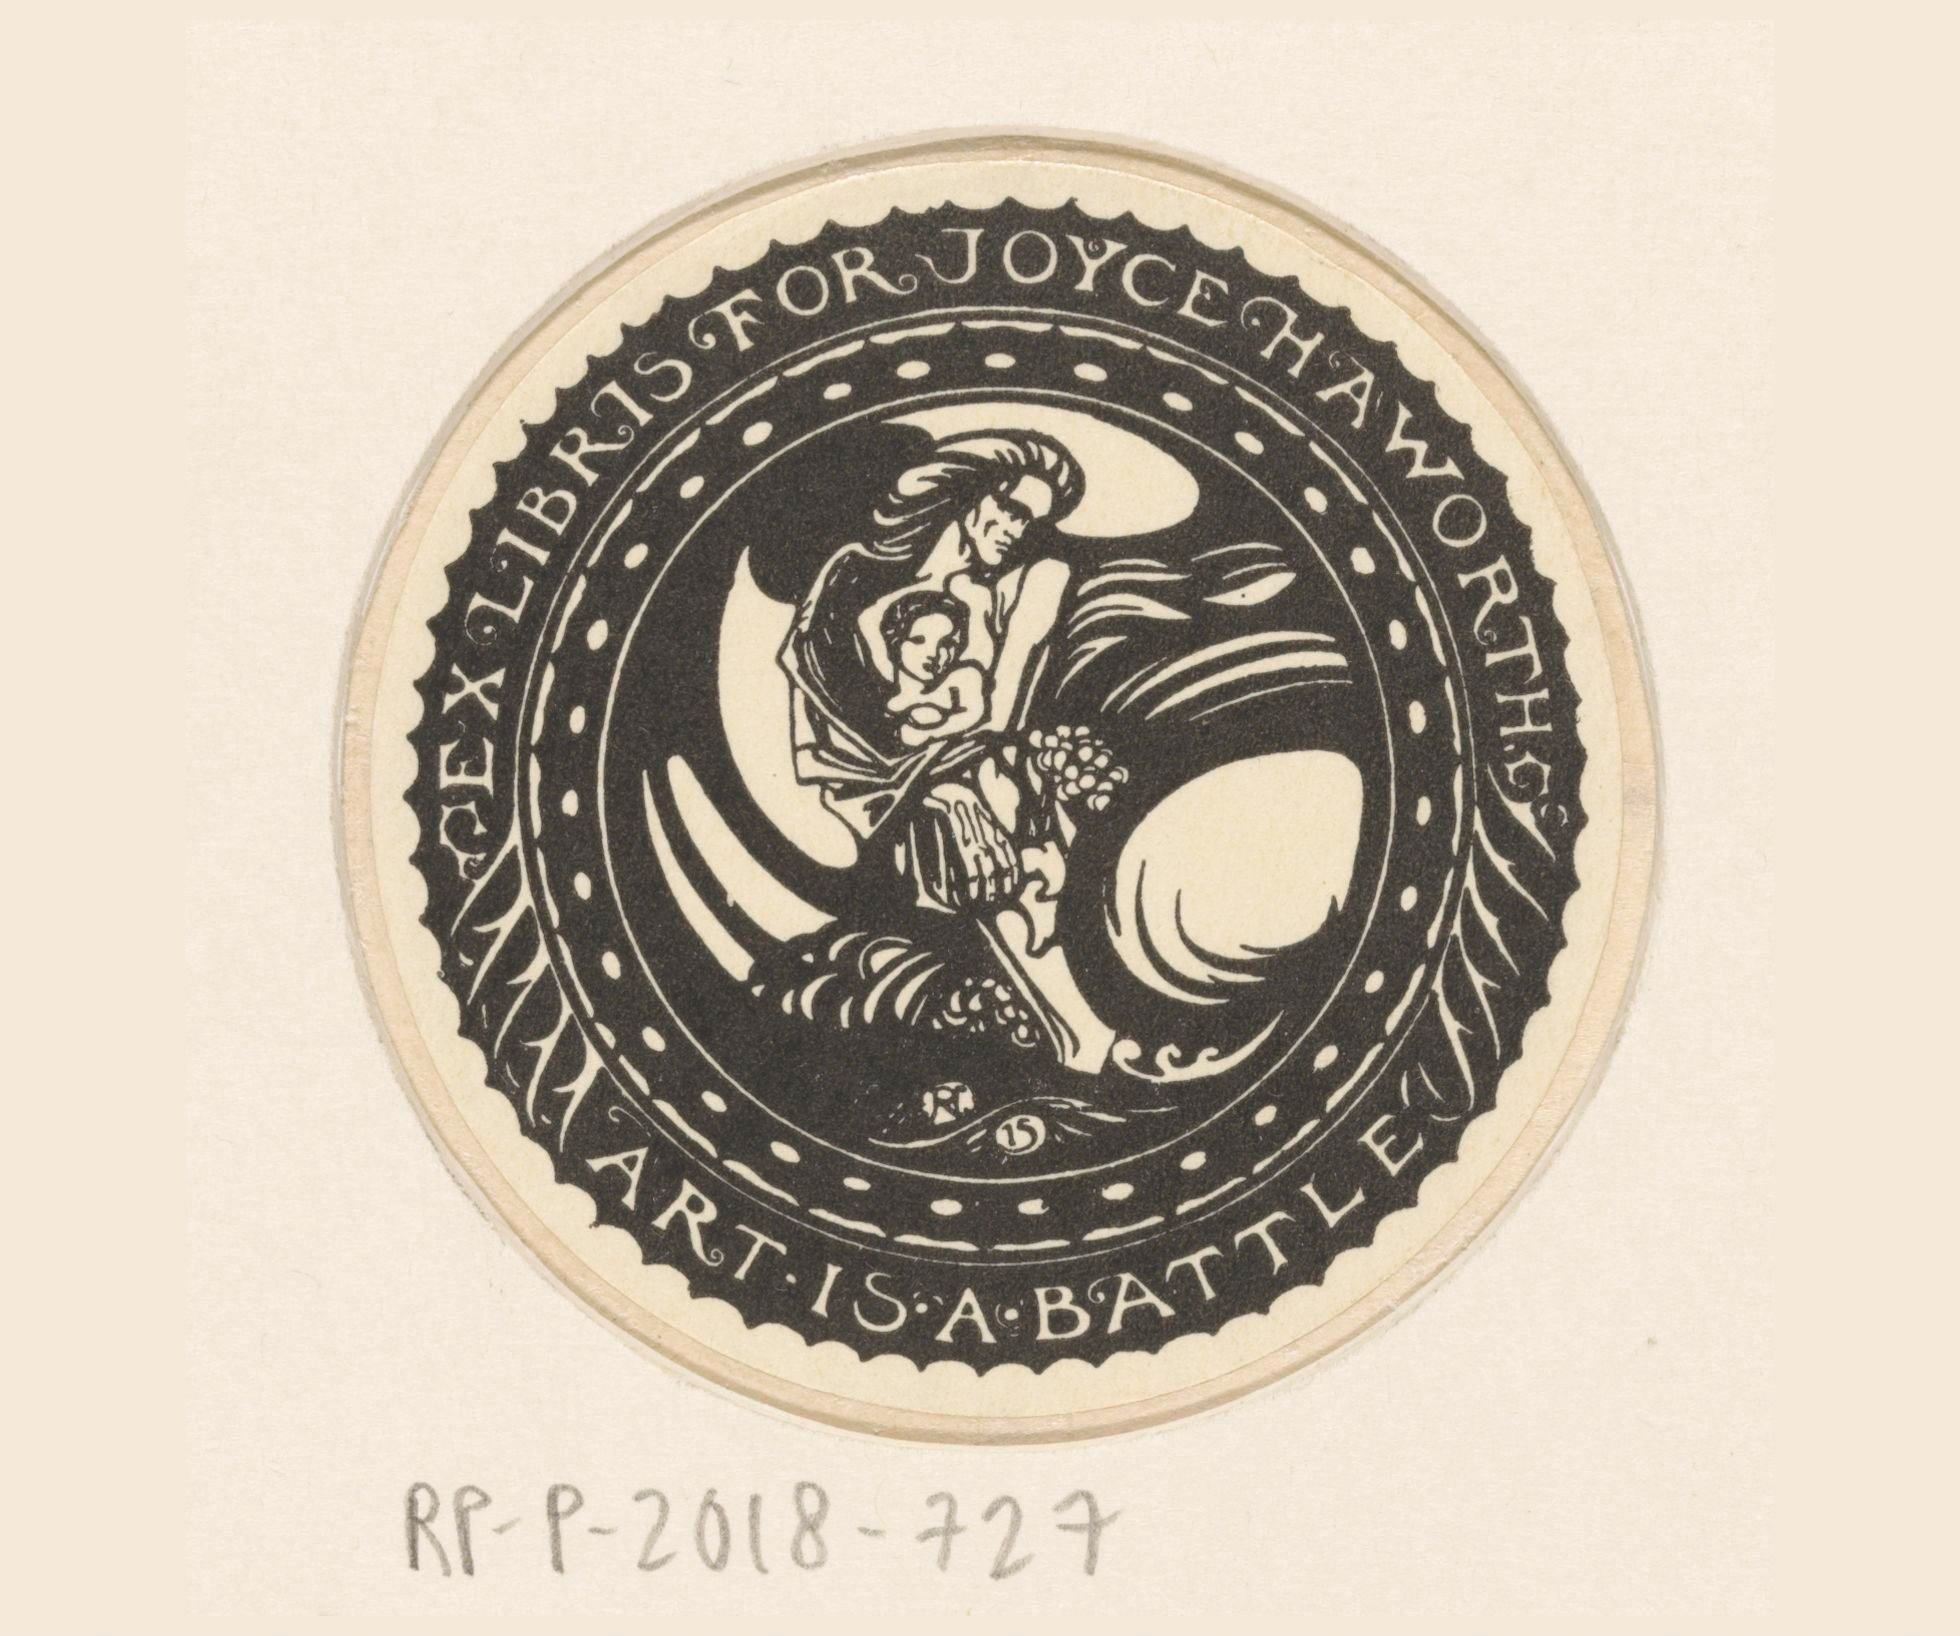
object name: bookplate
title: Art is a battle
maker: richard nicolaüs roland holst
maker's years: 1868-1938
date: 1915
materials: paper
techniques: line block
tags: mother and child(ren), woman and child(ren) (family group)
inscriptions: number: ‘43’